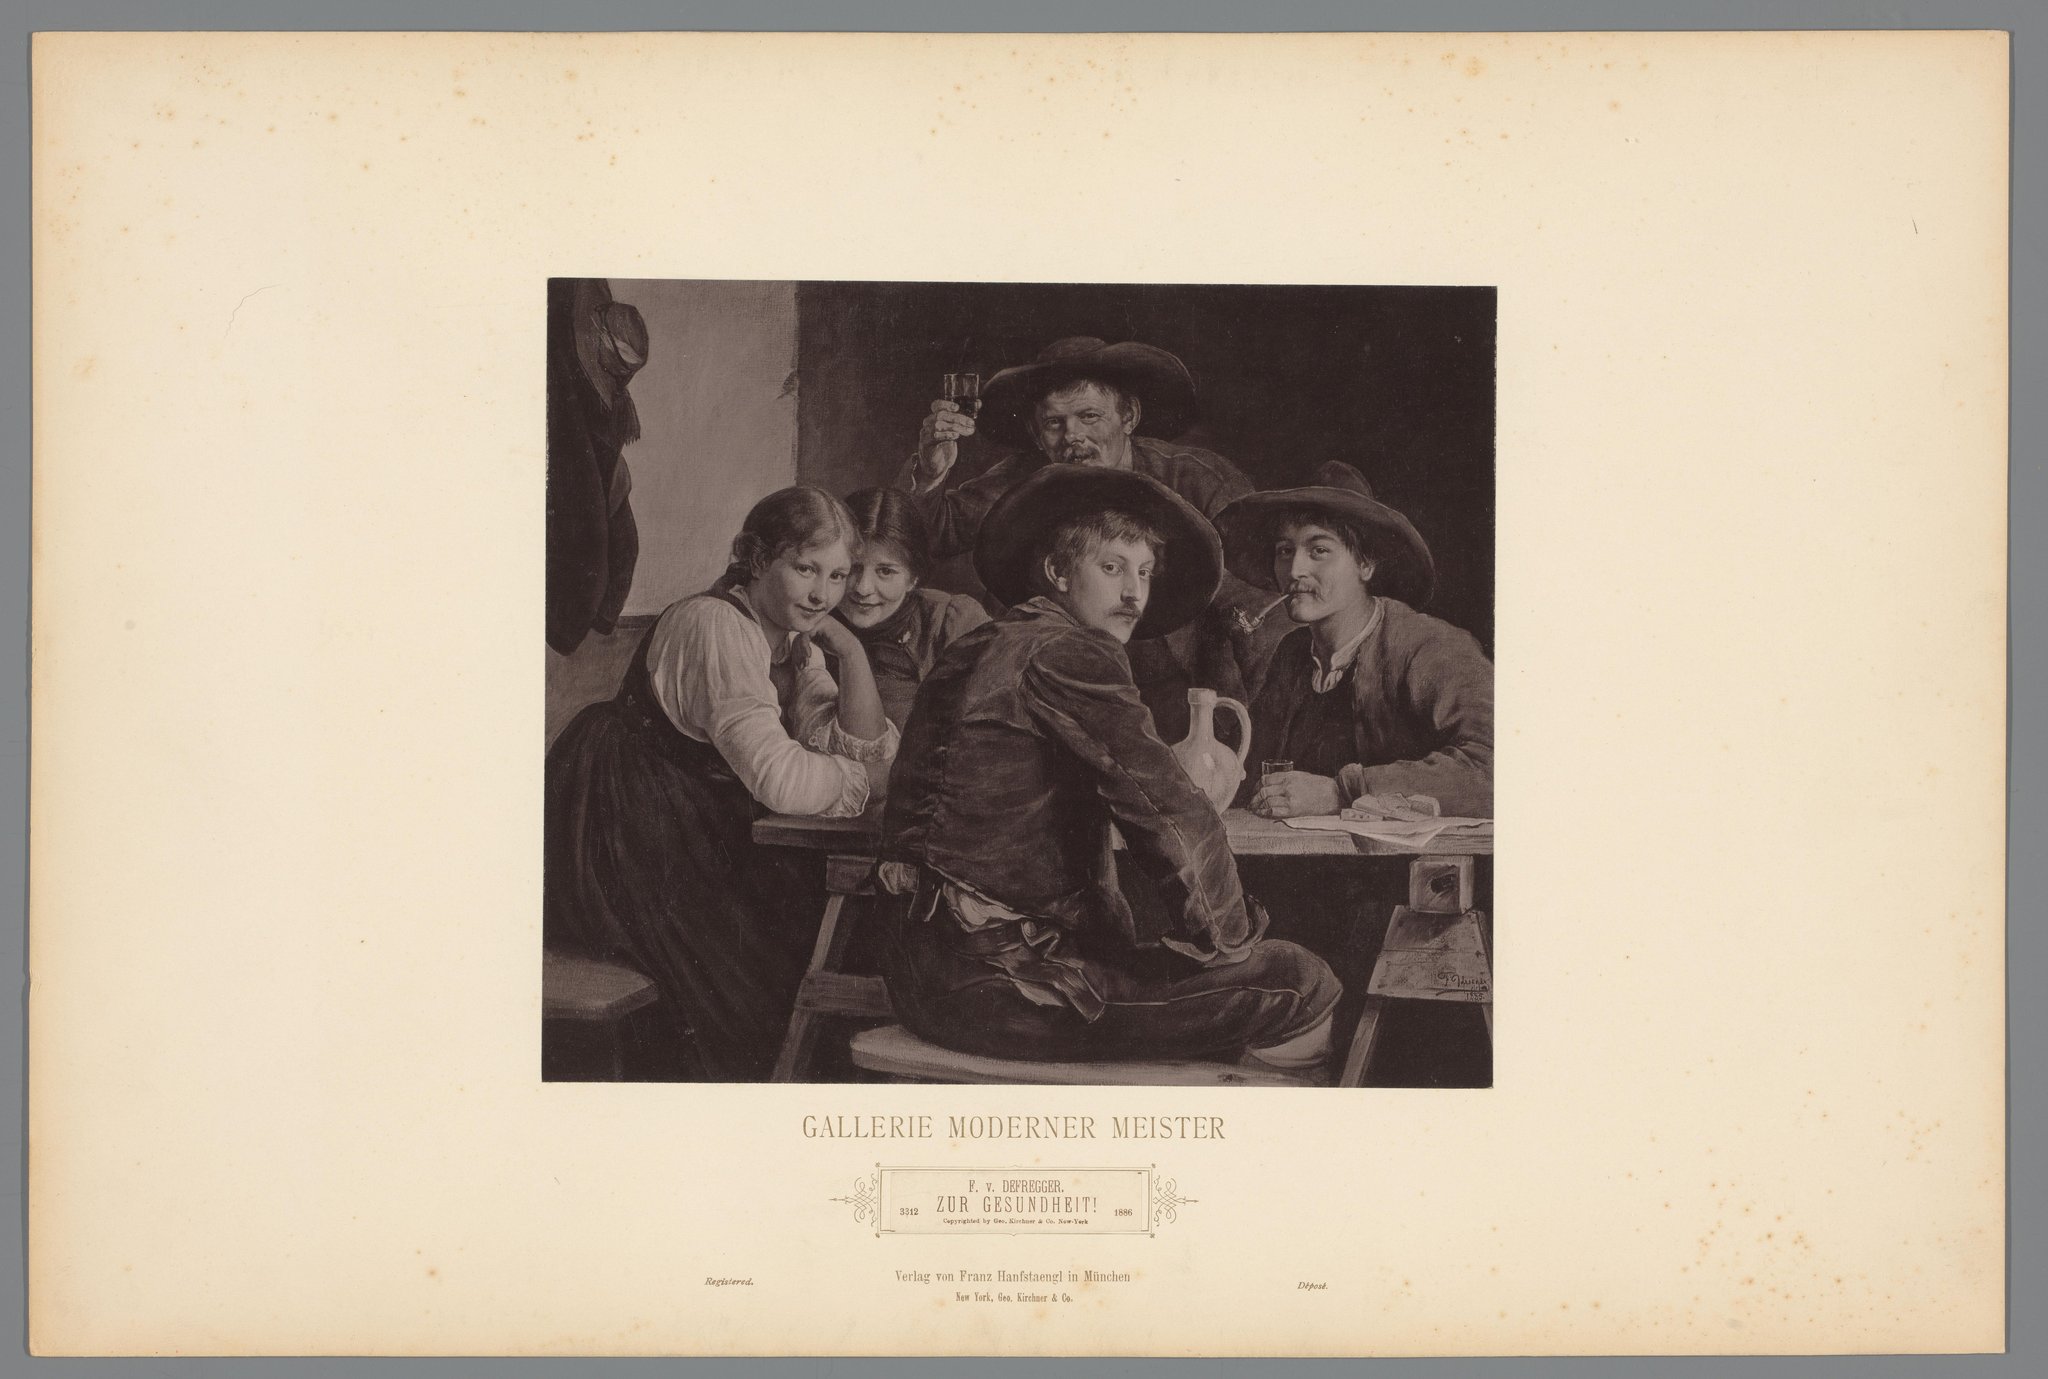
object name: photomechanical print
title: Zur Gesundheit!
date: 1886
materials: cardboard, paper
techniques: photograph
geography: new york city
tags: adult man (+ three persons), inn, coffee-house, public house, etc., adult woman (+ two persons)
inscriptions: inscription: ‘Registered. - Déposé.’, inscription: ‘F. v. Defregger/ 3312 ZUR GESUNDHEIT! 1886/ Copyrighted by Geo. Kirchner & Co. New York’